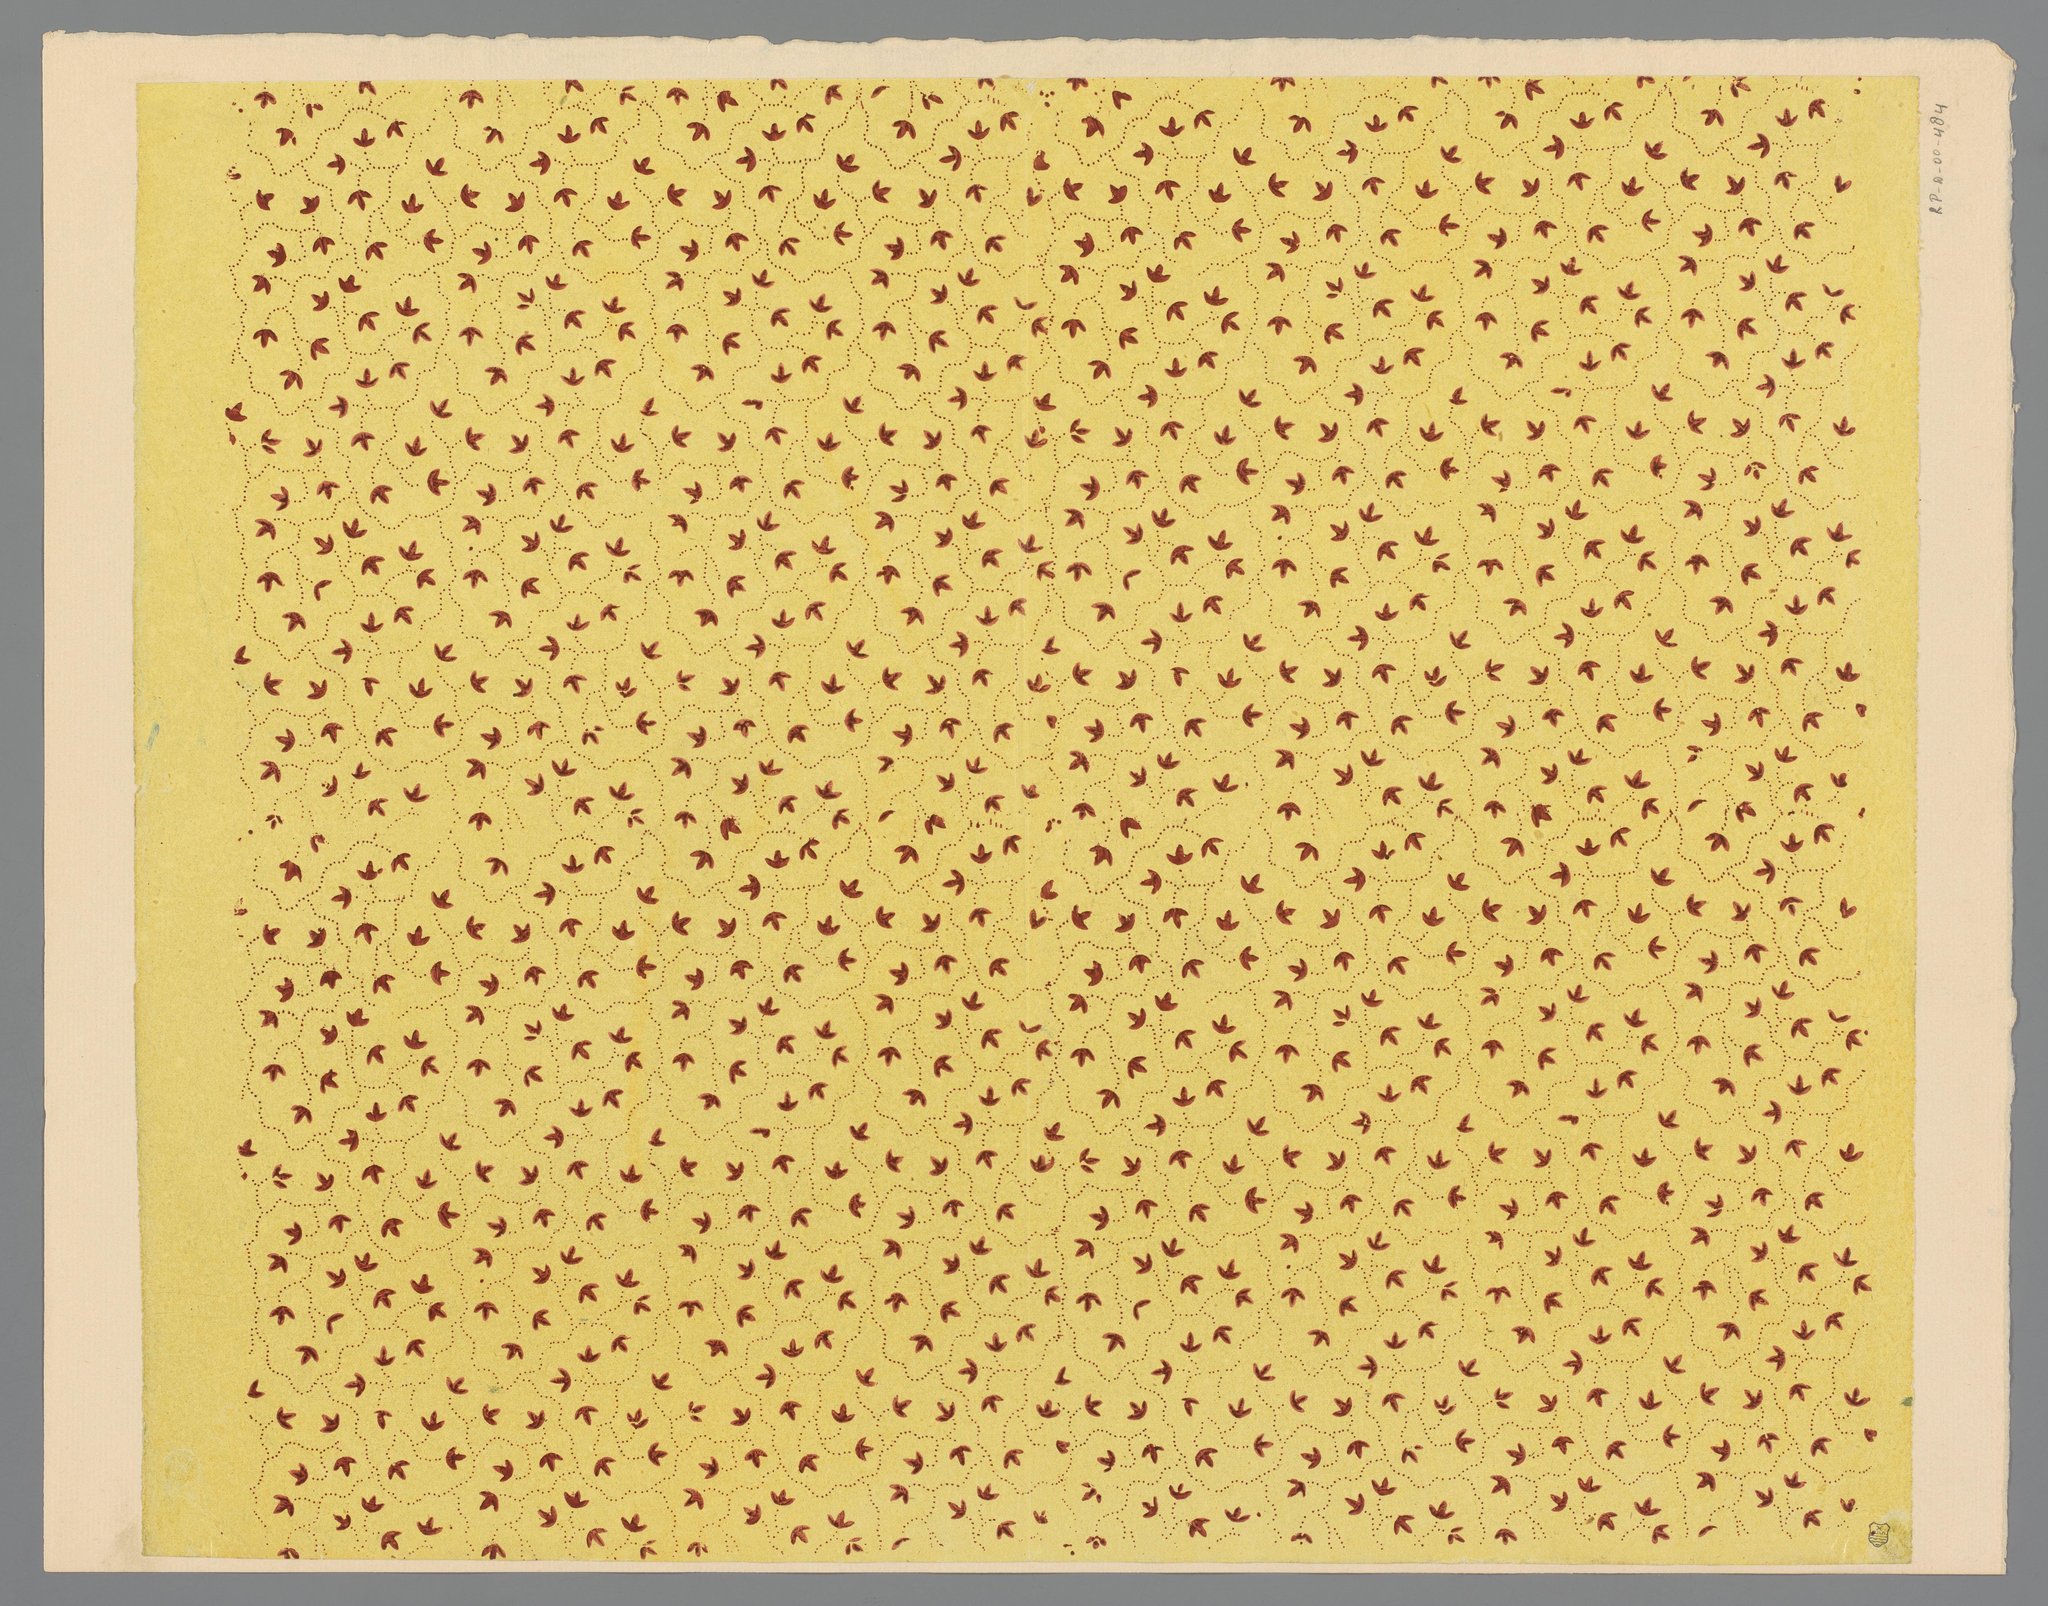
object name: printed paper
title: Blad met strooipatroon van bladmotief met kronkelende lijn van punten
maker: Anonymous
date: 1800-1900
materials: paint, paper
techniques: printing block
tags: ornament derived from plant forms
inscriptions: collector's mark: Lugt 2760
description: Blad met strooipatroon van een motief van drie bladeren aan kronkelende lijn van punten